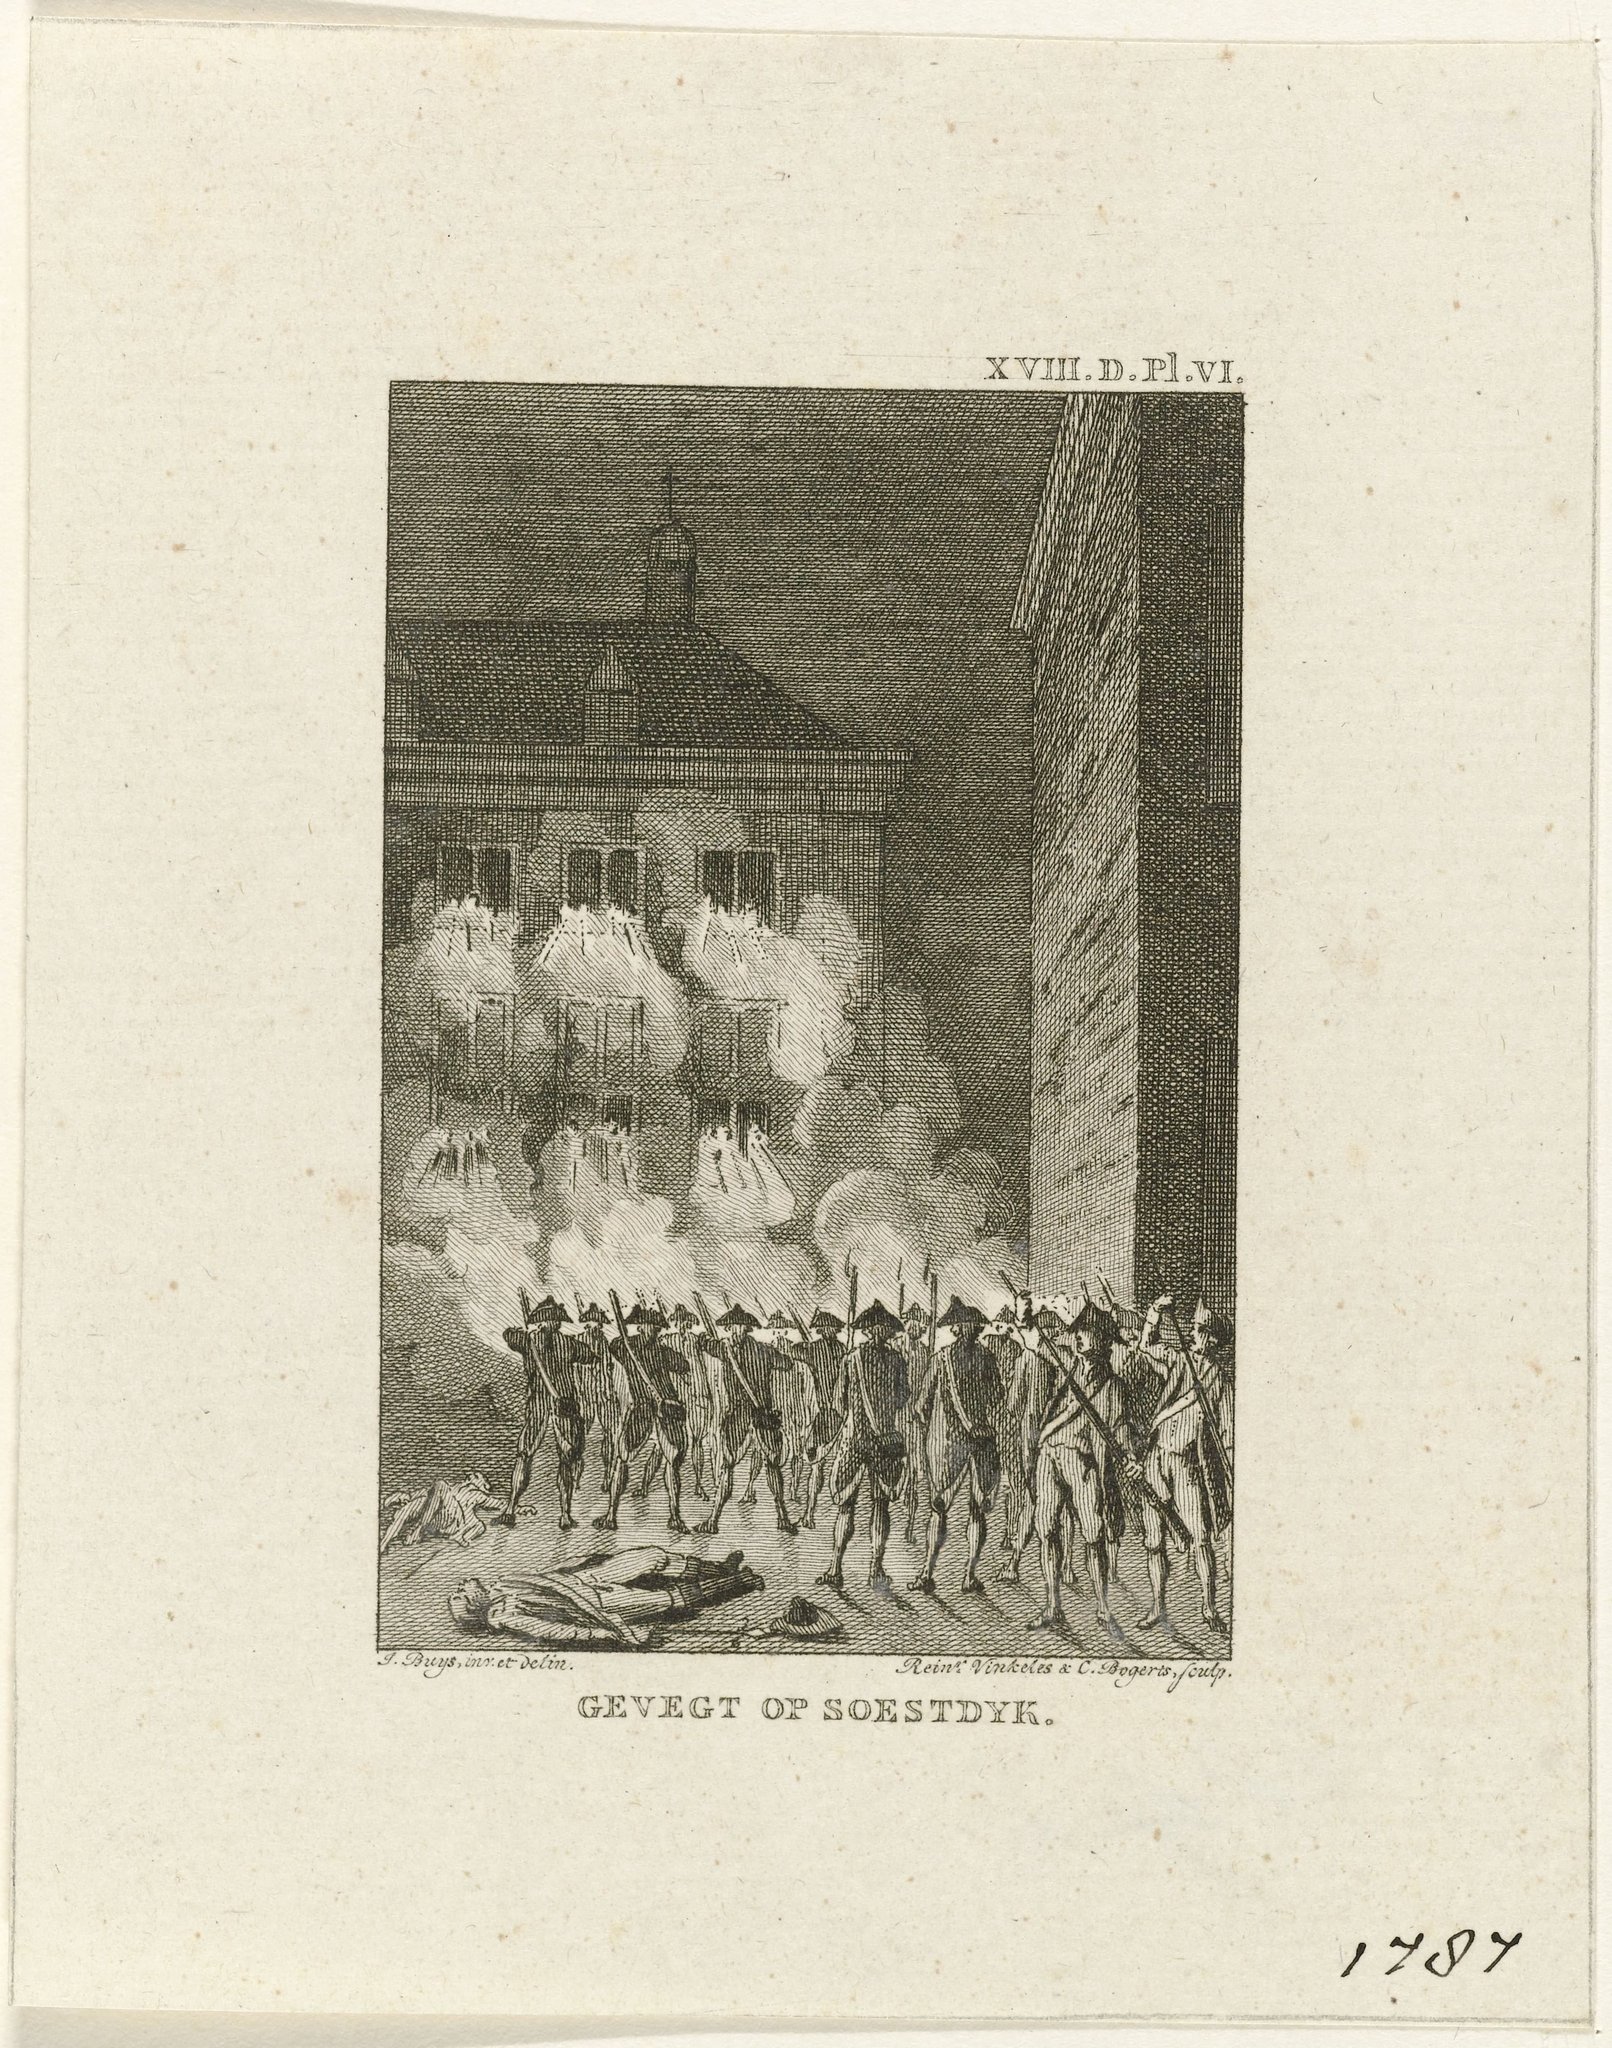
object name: print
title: Aanval op Soestdijk, 1787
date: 1787-1795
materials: paper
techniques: engraving, etching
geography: northern netherlands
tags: (military) attack (+ citizen soldiery, civil guard, citizen militia), patriots (1780-1795)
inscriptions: collector's mark: Lugt 2228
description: Het Paleis te Soestdijk aangevallen door patriotten uit Utrecht maar verdedigd door een detachement Duitse troepen, 27 juli 1787. Op de voorgrond het lichaam van de doodgeschoten soldaat Christoffel Pullman. Gemerkt bovenaan: XVIII.D.Pl.VI.